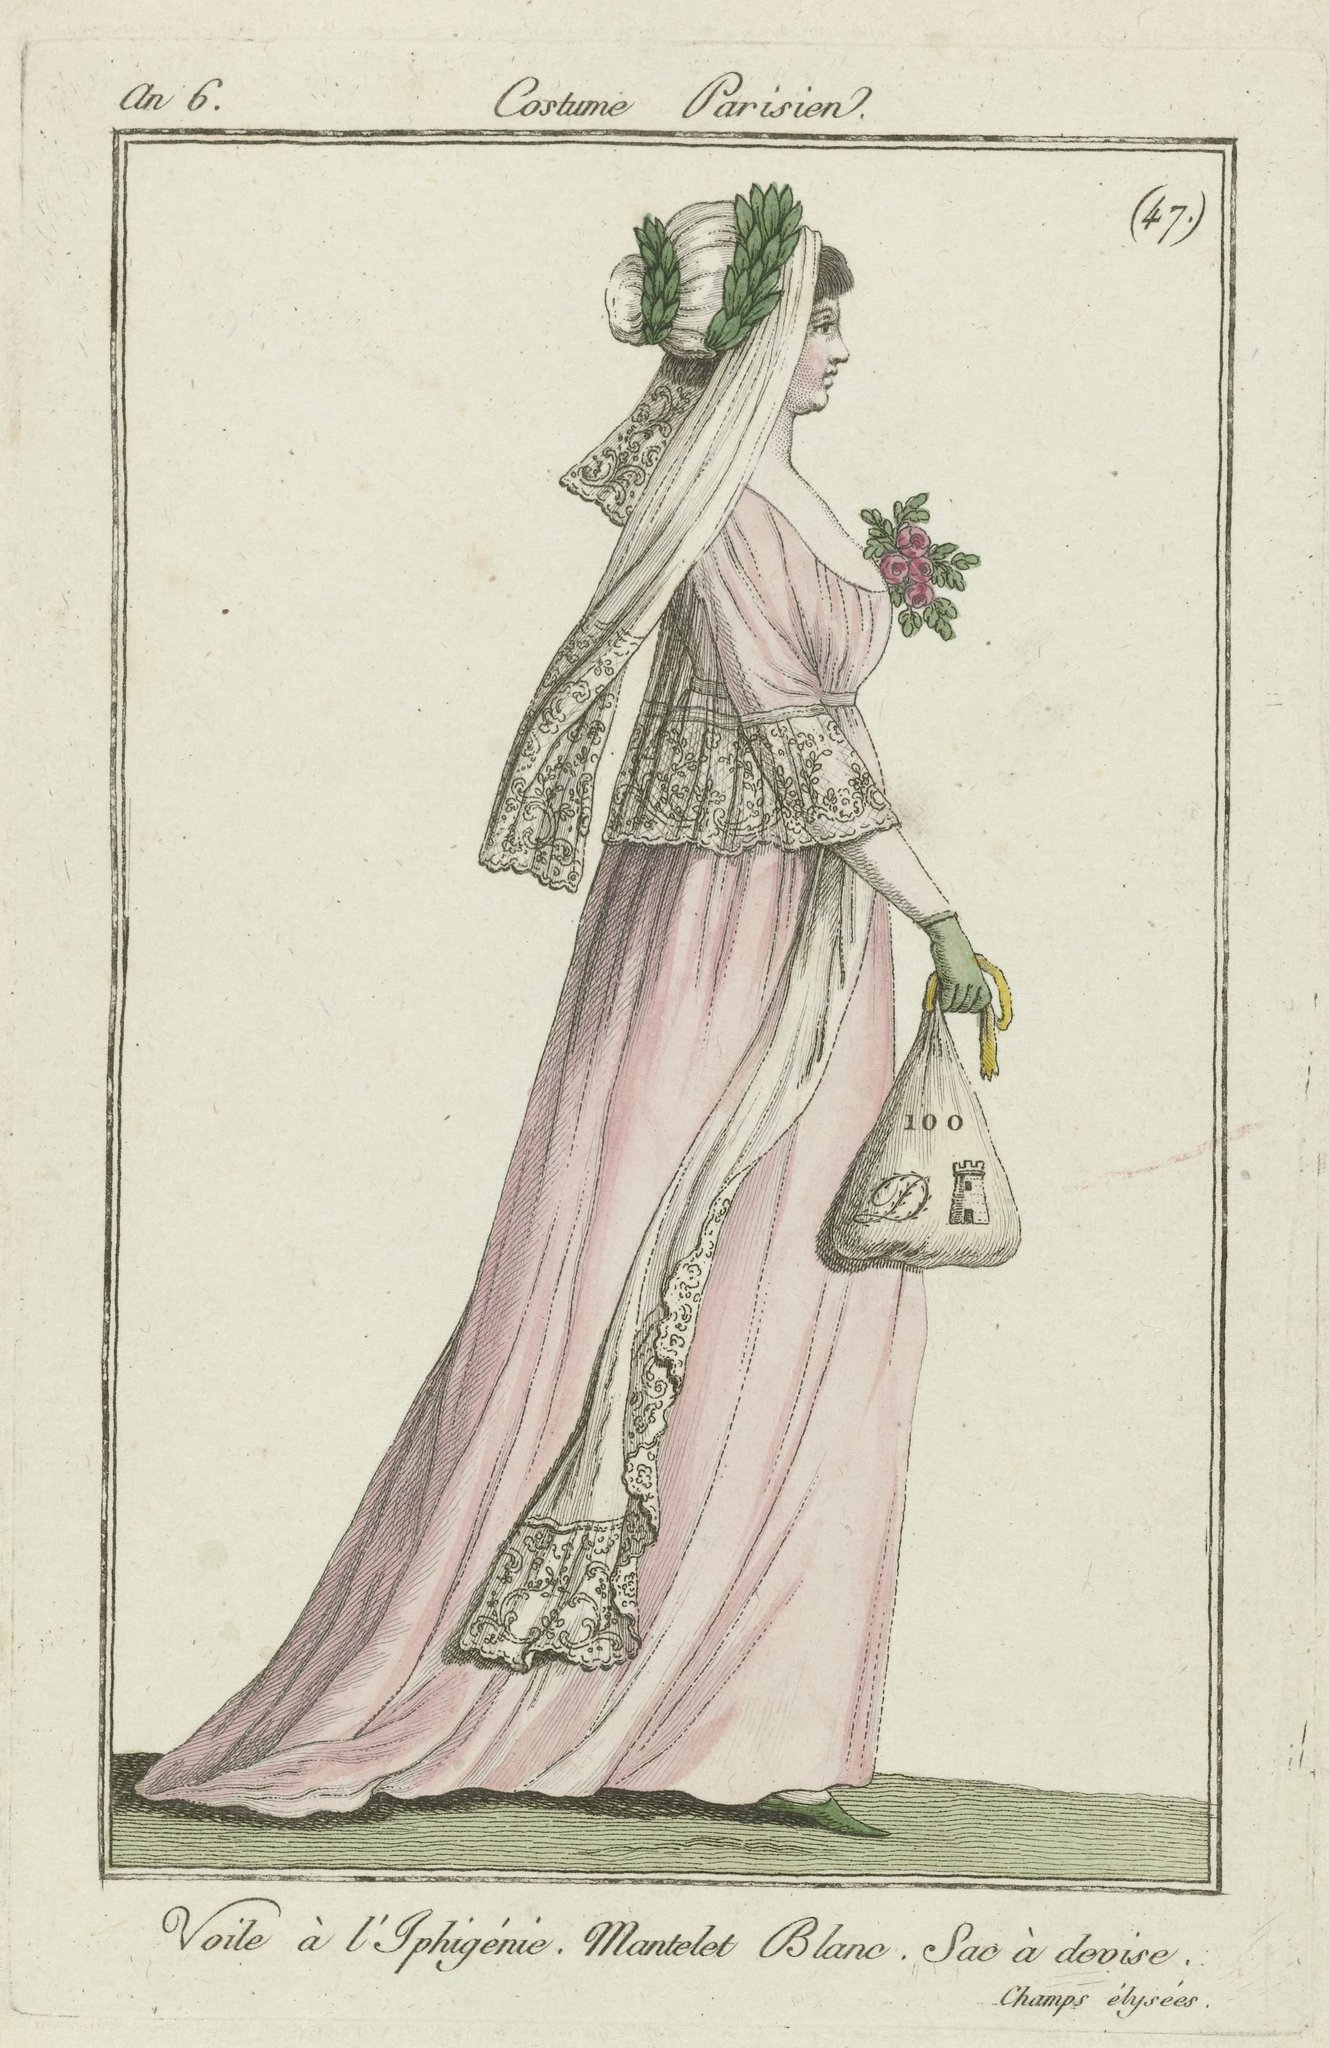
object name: fashion print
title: Journal des Dames et des Modes, Costume Parisien, 3 juillet 1798, An 6, (47) : Voile à l'Iphigénie (...)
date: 1798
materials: paper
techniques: engraving, hand coloring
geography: paris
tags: corsage (+ women's clothes), cut flowers; nosegay, bunch of flowers, veil (+ women's clothes), bag (handbag) (+ women's clothes), head-gear (+ women's clothes), fashion plates, shoes, sandals (+ women's clothes), gloves, mittens, etc. (+ women's clothes), dress, gown (+ women's clothes)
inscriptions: title: ‘Costume Parisien.’, caption: ‘Voile à l'Iphigénie. Mantelet Blanc. Sac à devise. / Champs élysées.’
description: Vrouw, lopend naar rechts, met een sluier: 'Voile à l'Iphigénie'. Zij draagt een kleine witte schoudermantel op een japon met sleep. In de rechterhand een tas of 'sac' met devies. Verdere accessoires: bloemcorsage, handschoen, platte schoen met puntige neus. Volgens het onderschrift is deze voorstelling naar het leven getekend op de 'Champs Élysées'. De prent maakt deel uit van het modetijdschrift Journal des Dames et des Modes, uitgegeven door Sellèque, Parijs, 1797-1839.